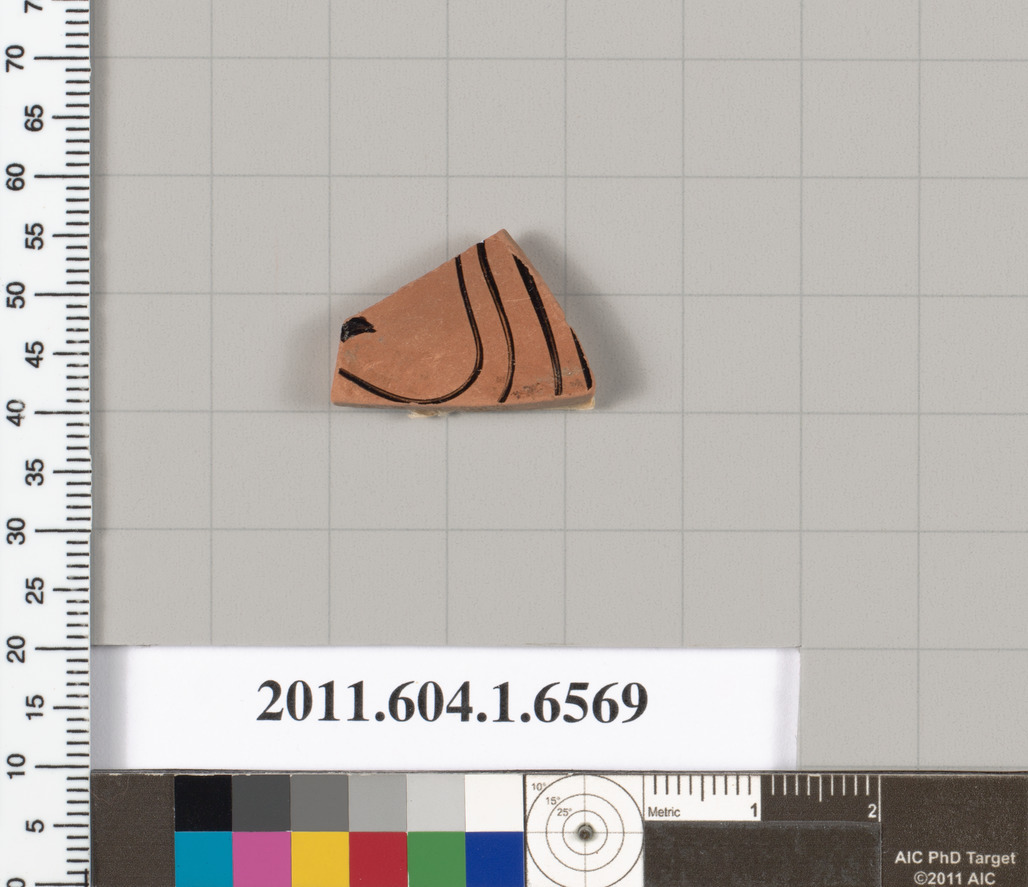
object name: kylix fragment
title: Terracotta fragment of a kylix (drinking cup)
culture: greek, attic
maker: colmar painter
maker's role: artist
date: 490-480 BCE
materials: terracotta